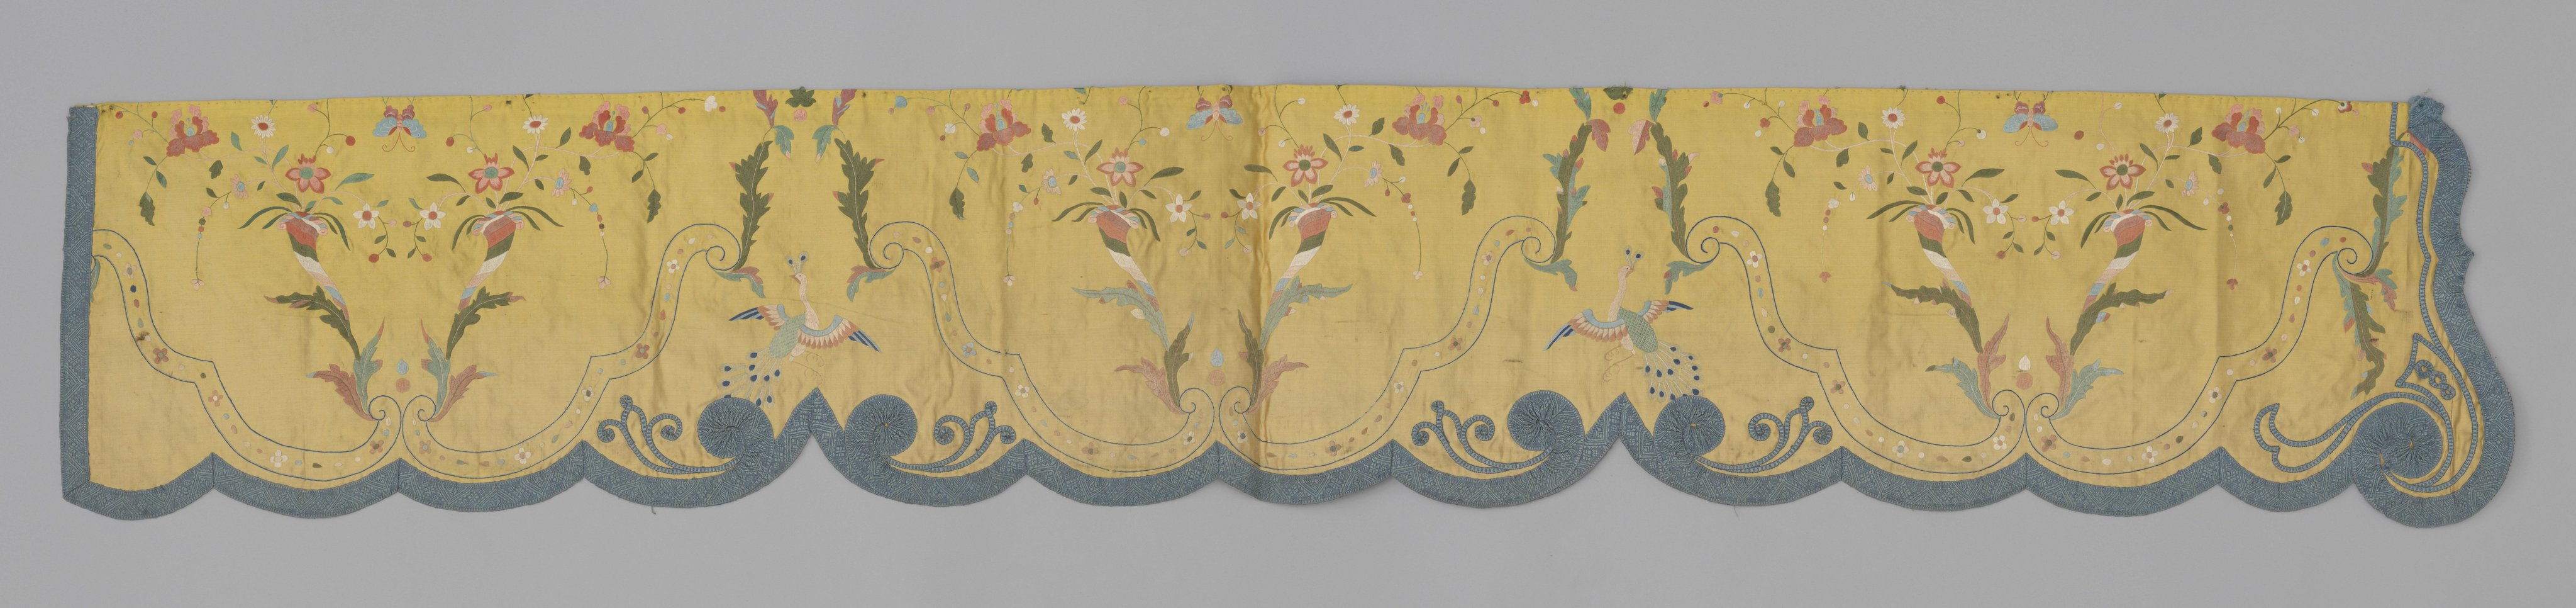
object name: silk textile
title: Matrasomhang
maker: Anonymous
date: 1720-1740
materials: linen, silk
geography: guangdong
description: Geel zijden matrasomhang van een bedgarnituur geborduurd met pauwen, bloemen, vlinders, hoorns van overvloed in veelkleurige zijde, omboord en versierd met blauw passement, gevoerd met grof linnen. Bestemd voor linkerkant van het bed.